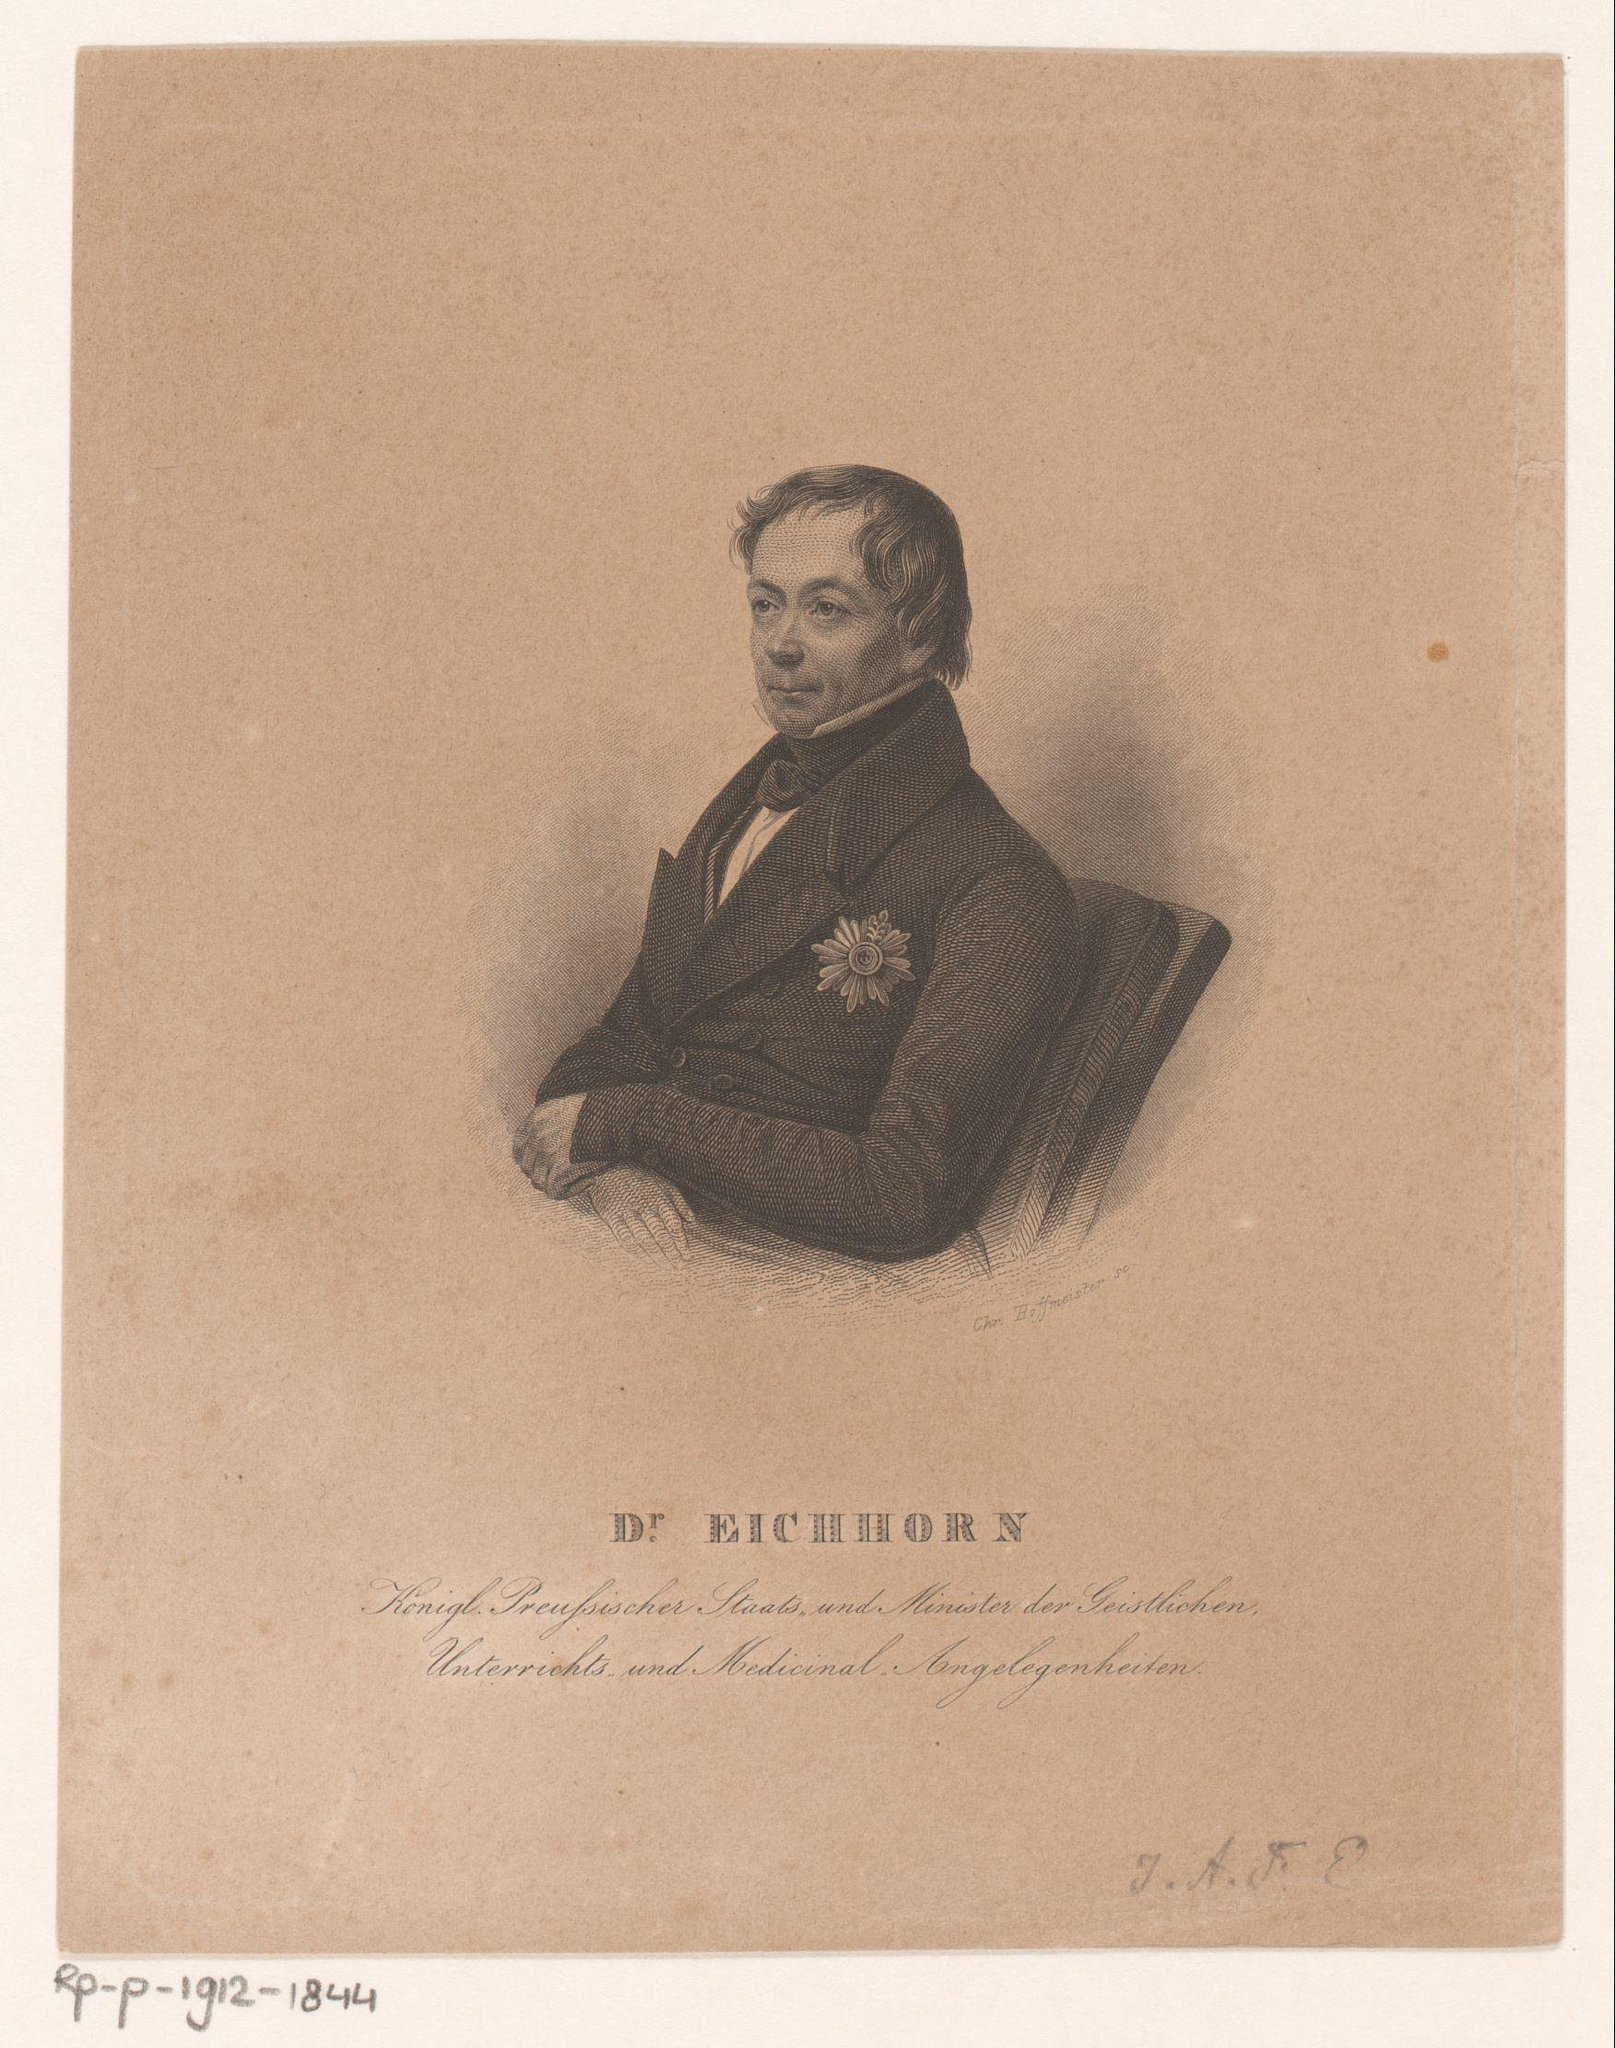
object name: print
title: Portret van Friedrich Eichhorn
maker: christian hoffmeister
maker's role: print maker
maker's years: 1818-1871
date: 1828-1856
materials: paper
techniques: engraving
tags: berlin, knighthood order, historical persons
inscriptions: collector's mark: Lugt 2228